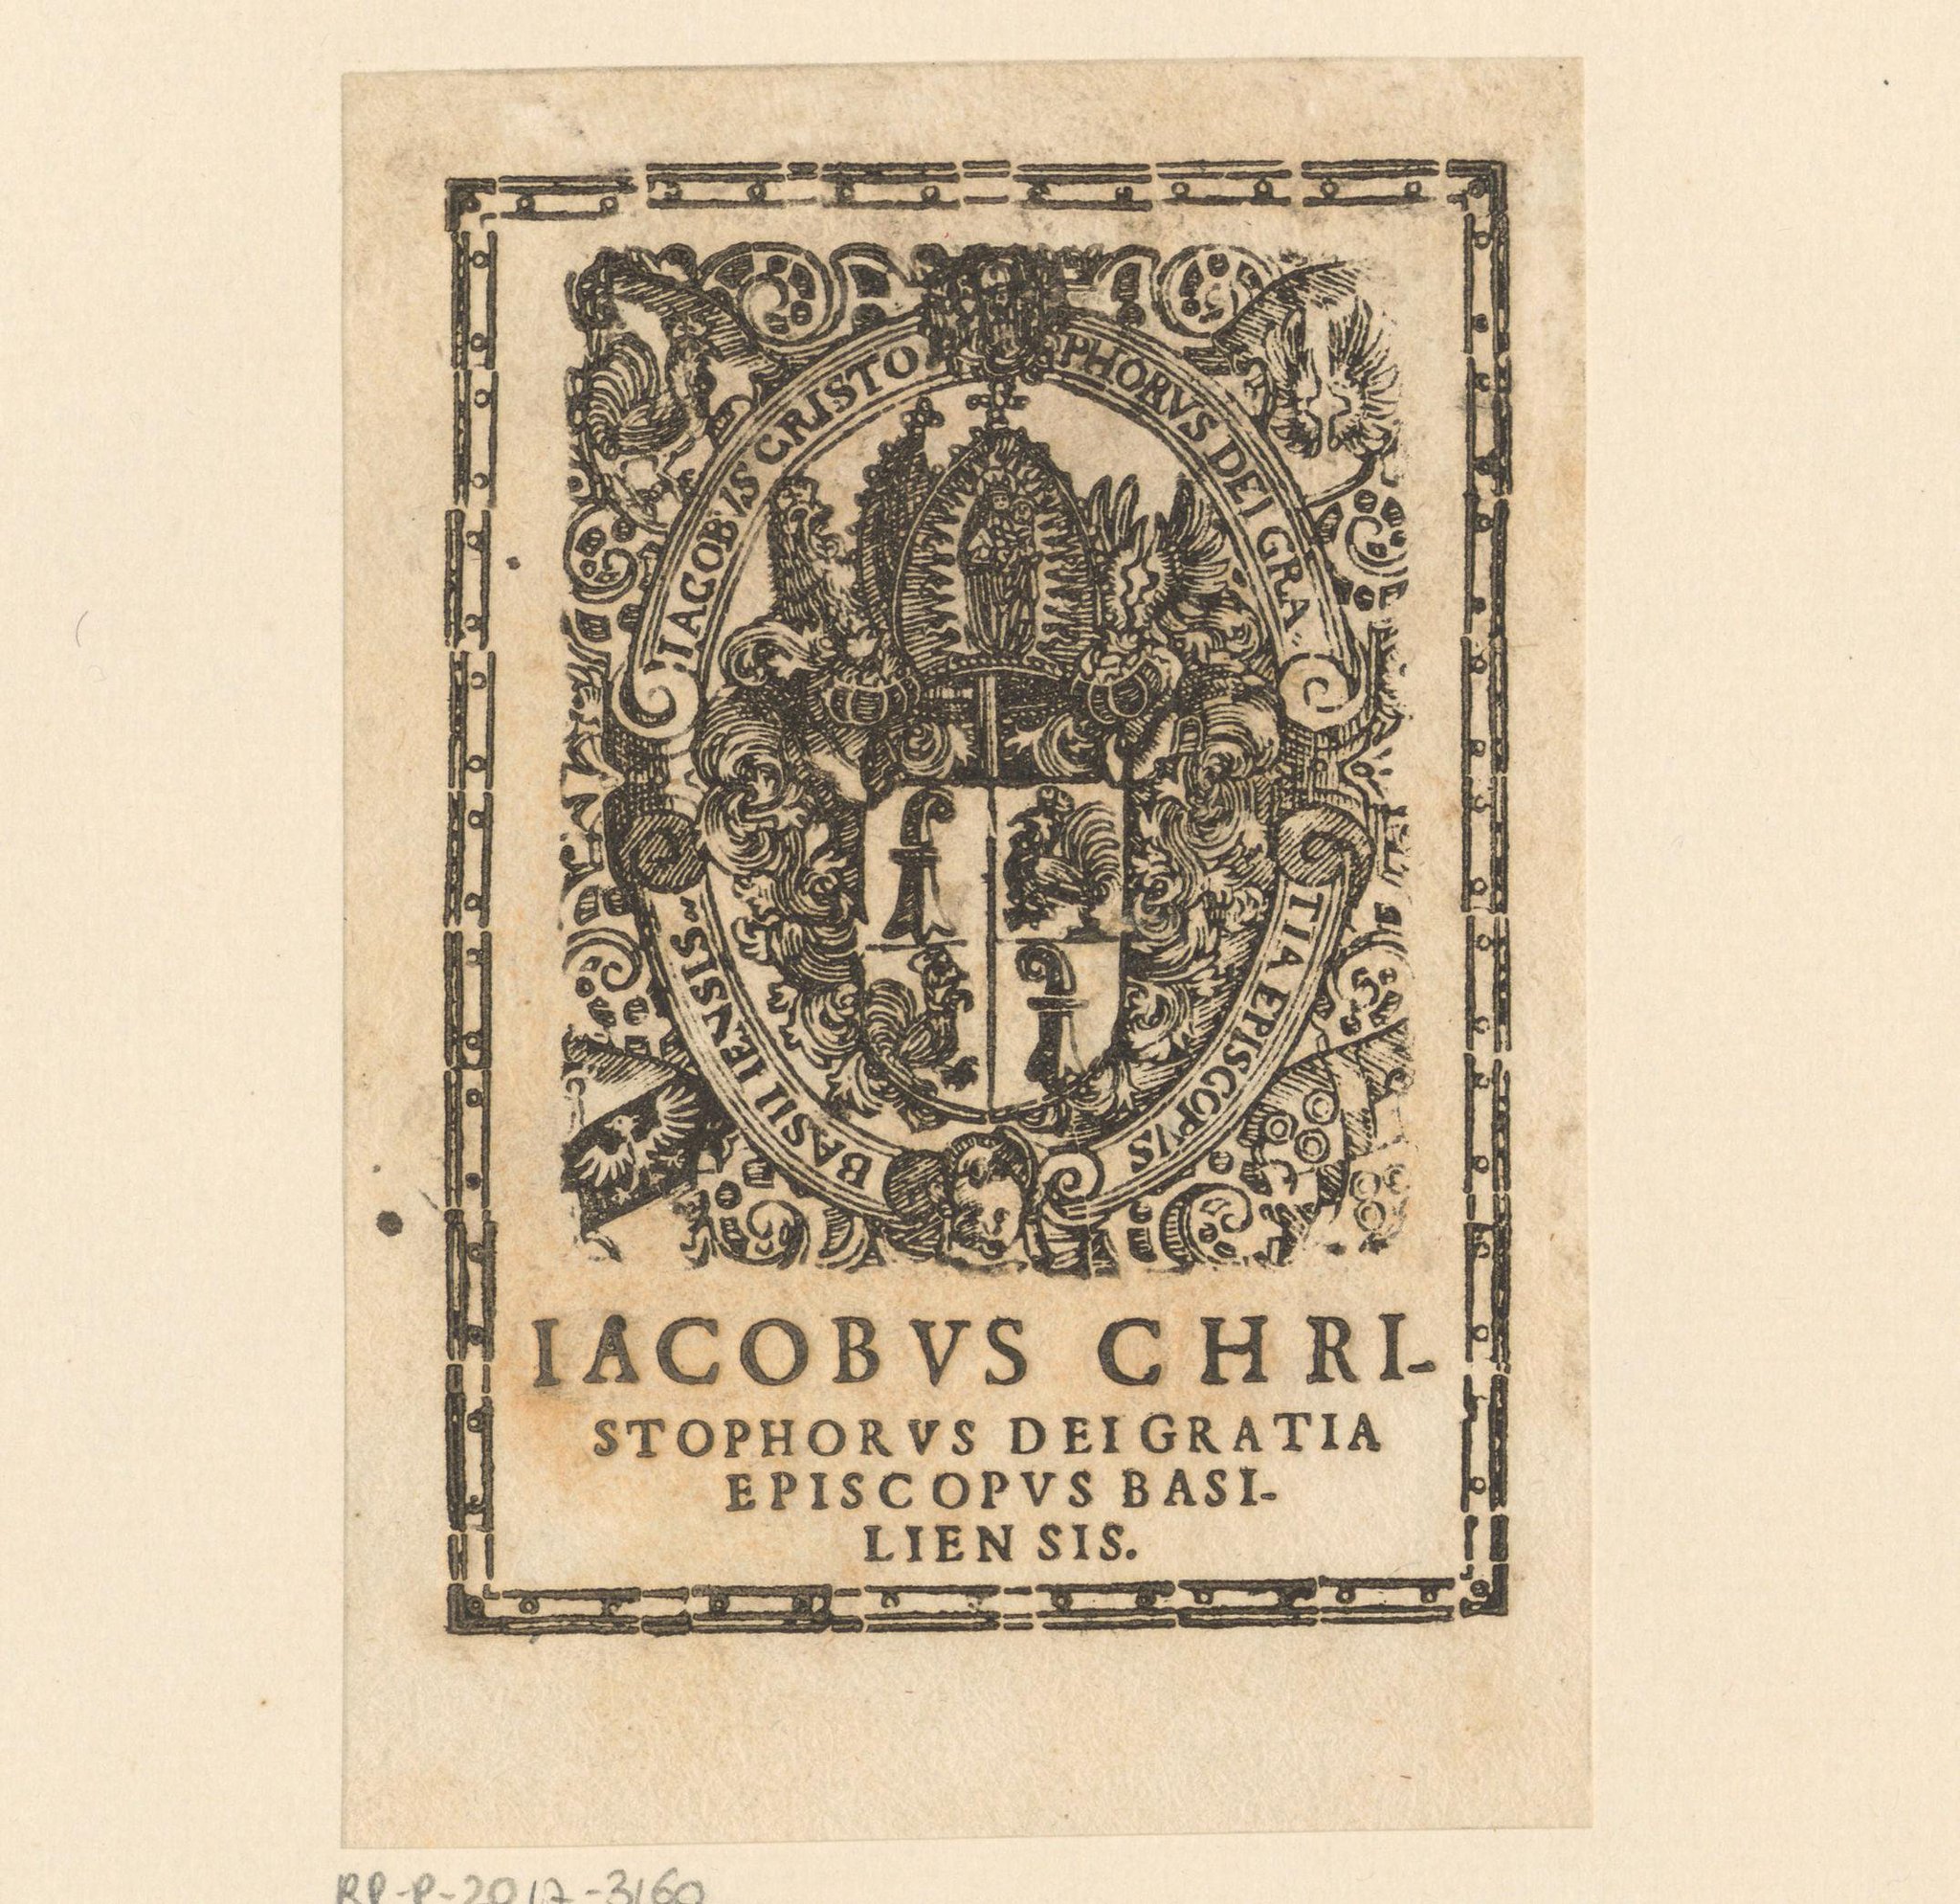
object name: bookplate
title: Ex libris van Iacobus Christophorus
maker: Anonymous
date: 1550-1650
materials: paper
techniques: letterpress printing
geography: basel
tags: madonna: i.e. mary with the christ-child, insignia of bishop, e.g. mitre, crozier, armorial bearing, heraldry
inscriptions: inscription: ‘Basel / Gerster 101 / 1575-1608’